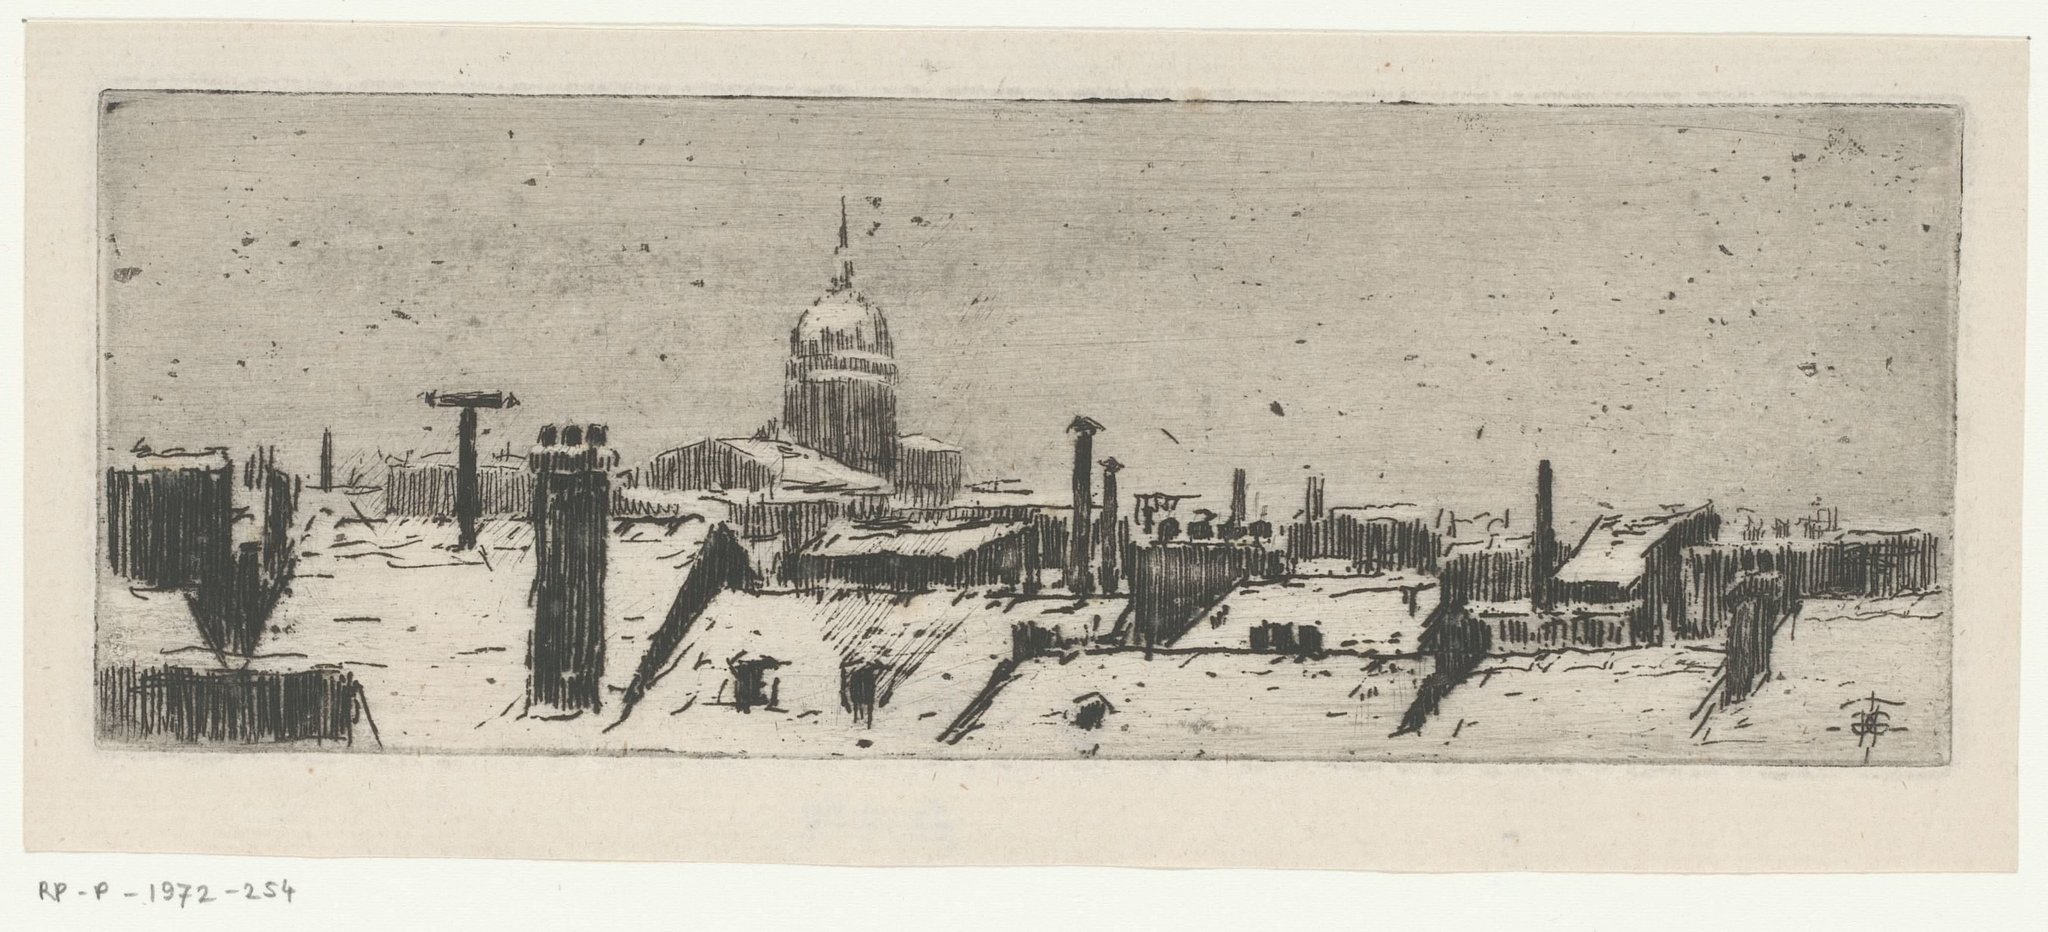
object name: print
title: Sneeuwgezicht op Parijs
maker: henri charles guérard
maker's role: print maker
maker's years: 1846-1897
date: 1856-1897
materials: paper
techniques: etching, intaglio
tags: city-view in general; 'veduta', paris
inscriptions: collector's mark: Lugt 2228, collector's mark: Lugt 2760